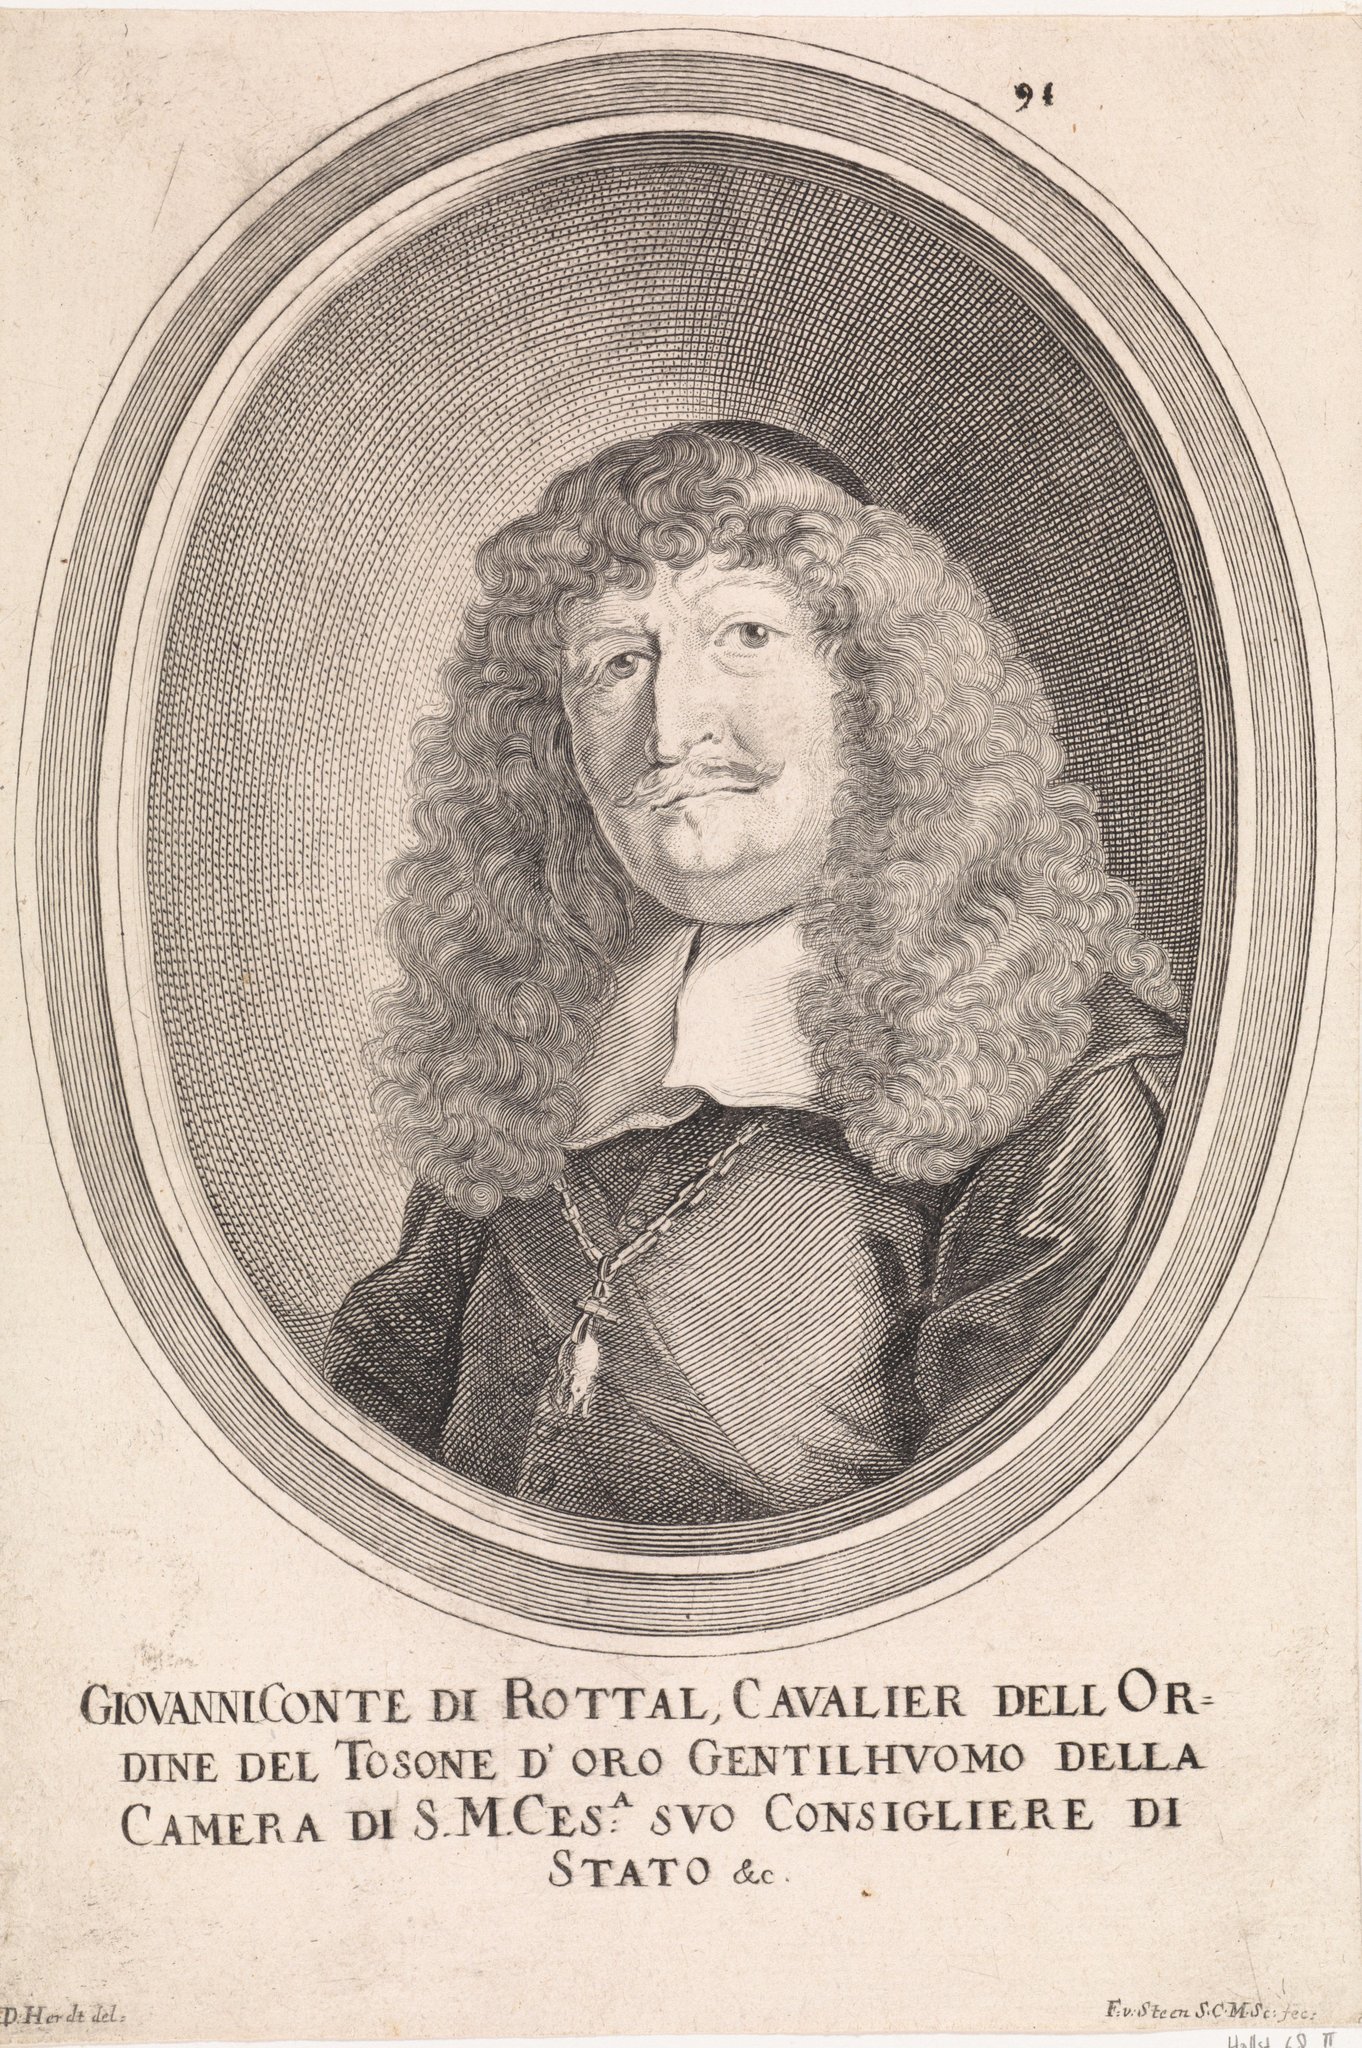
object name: book illustration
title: Portret van Johann Anton graaf van Rottal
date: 1670-1674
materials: paper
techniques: engraving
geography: vienna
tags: vienna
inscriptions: collector's mark: Lugt 2228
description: Portret van Johann Anton graaf van Rottal met aan een ketting op zijn borst het ordeteken van de Orde van het Gulden Vlies. Onderaan in de marge een vierregelige tekst in het Italiaans. Rechtsboven genummerd: 91.